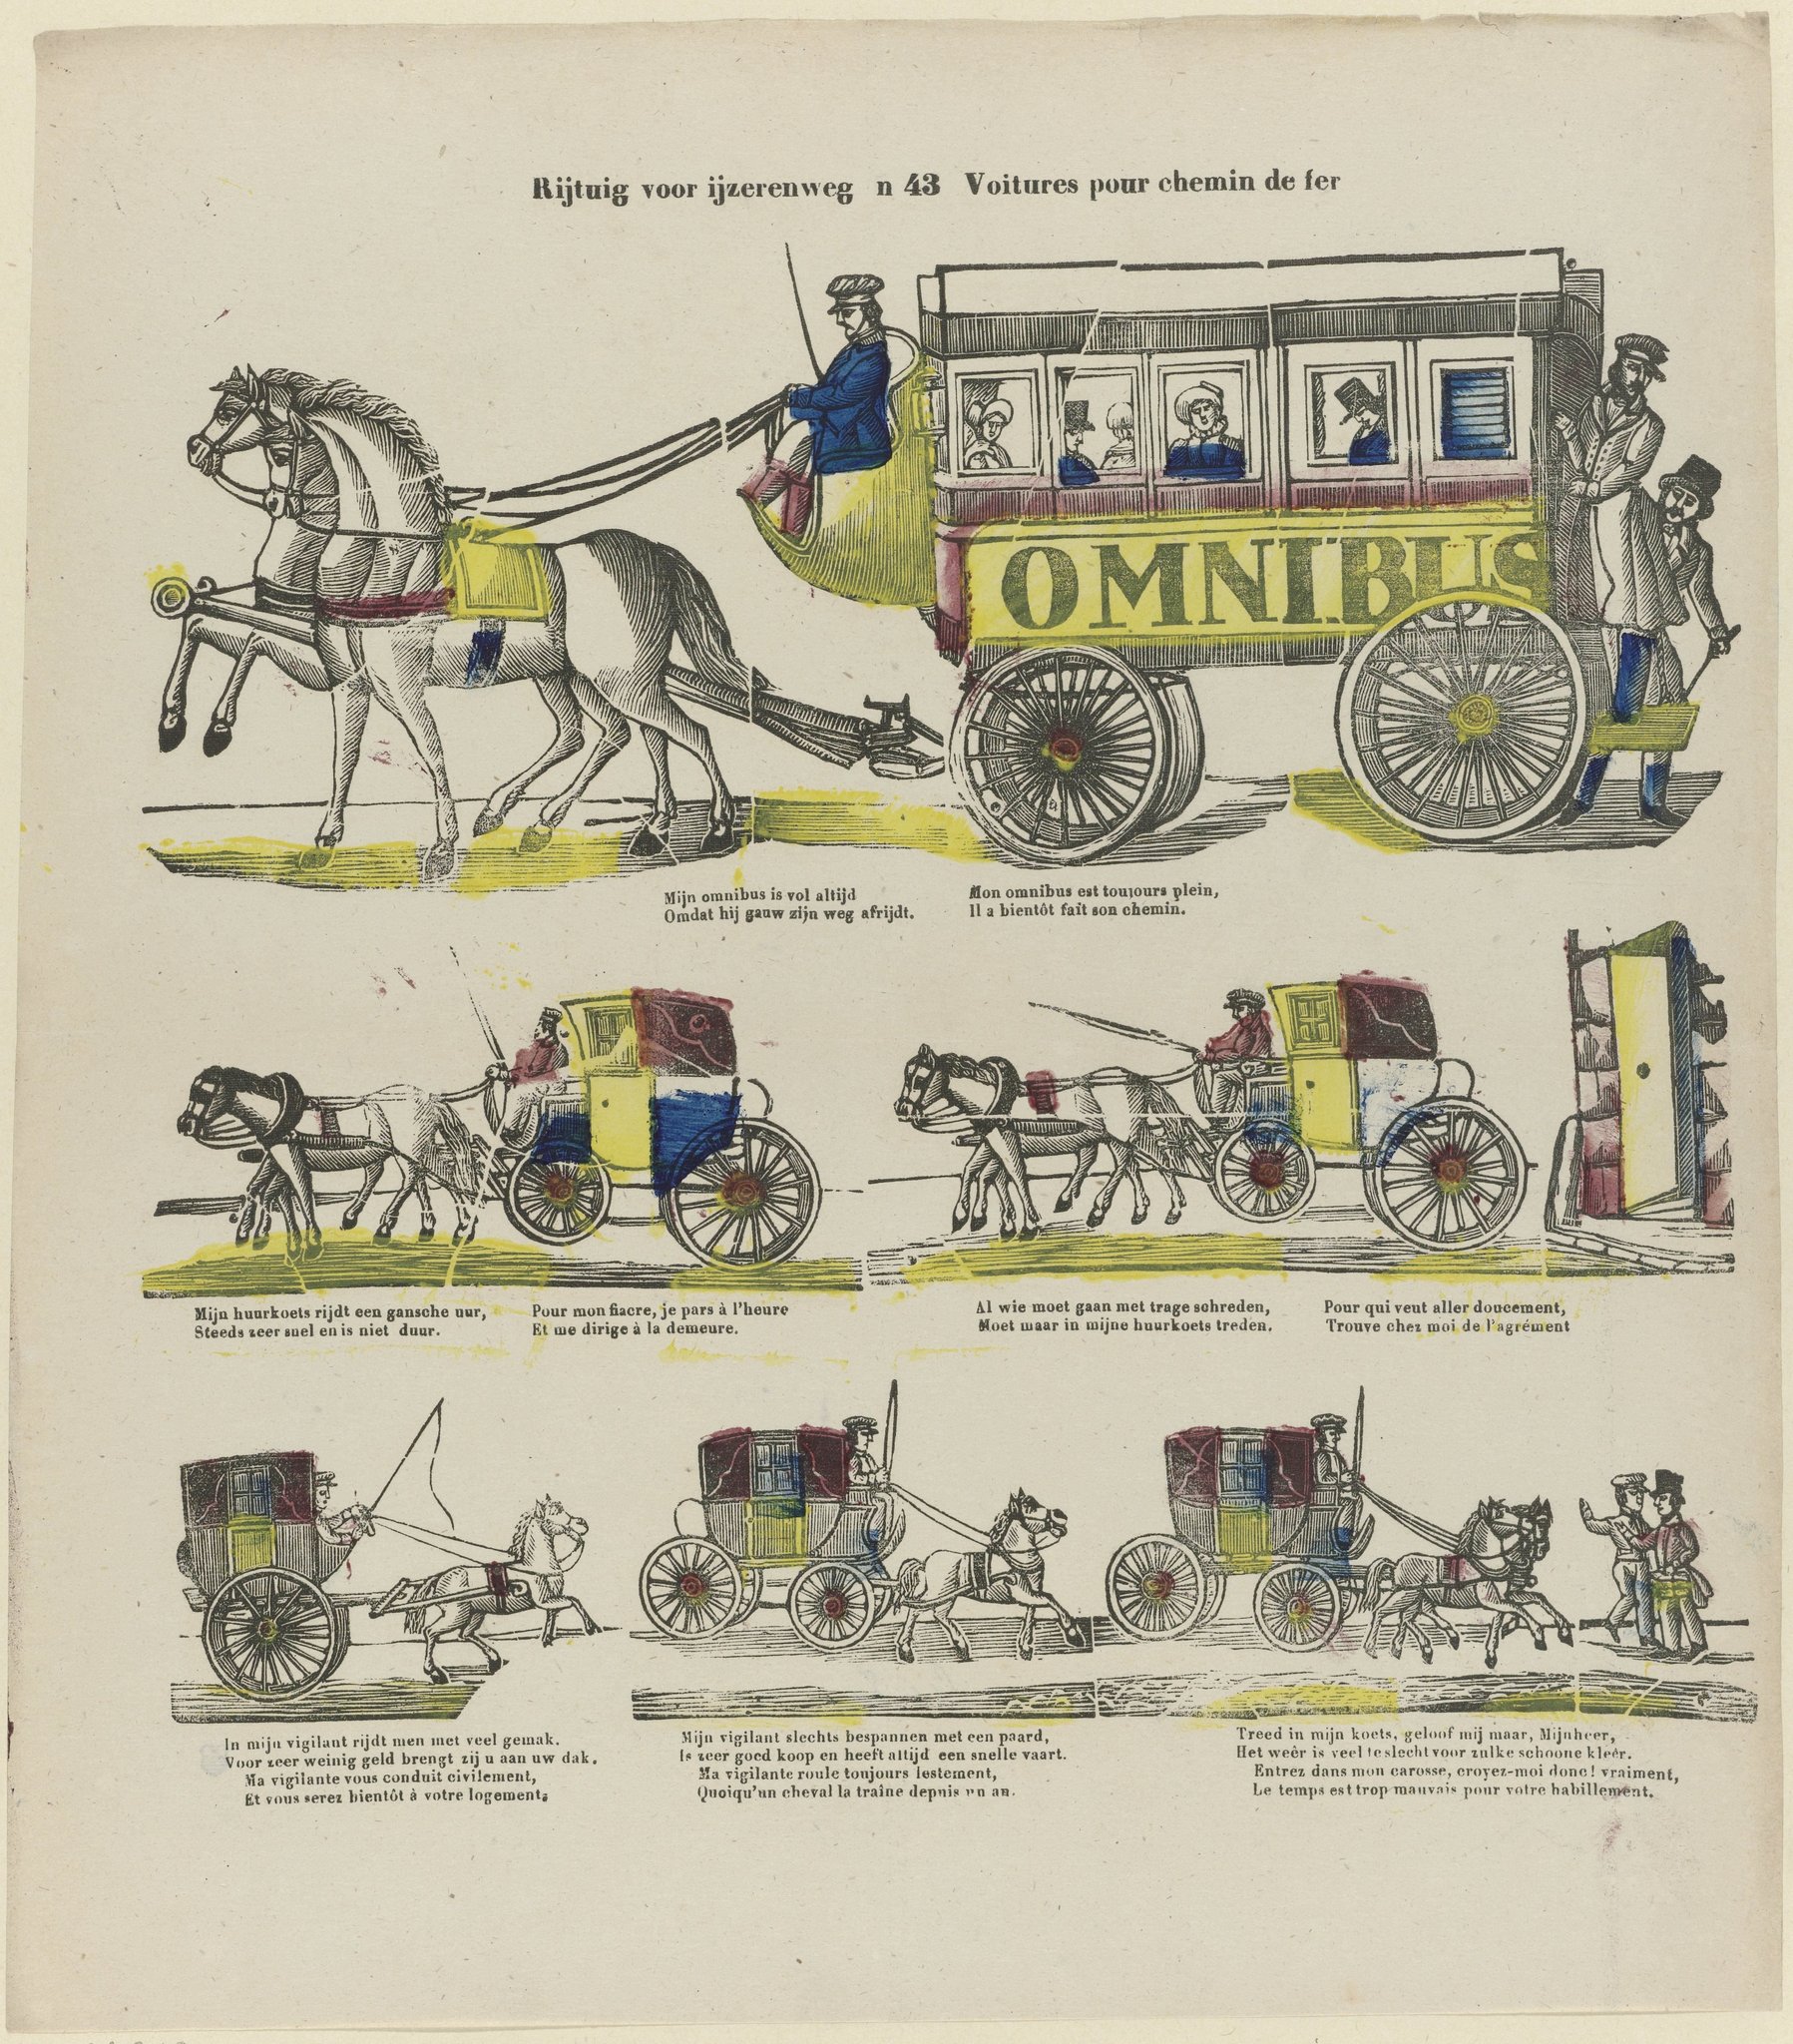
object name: print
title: Rijtuig voor ijzerenweg / Voitures pour chemin de fer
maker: Anonymous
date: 1856-1900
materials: paper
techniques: colour, letterpress printing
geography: turnhout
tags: diligence, omnibus, horse-tram, four-wheeled, animal-drawn vehicle, e.g.: cab, carriage, coach, two-wheeled vehicle drawn by one animal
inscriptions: collector's mark: Lugt 2760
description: Blad met 8 voorstellingen van verschillende rijtuigen. Onder elke voorstelling een onderschrift in het Nederlands en in het Frans. Genummerd midden boven: n 43.